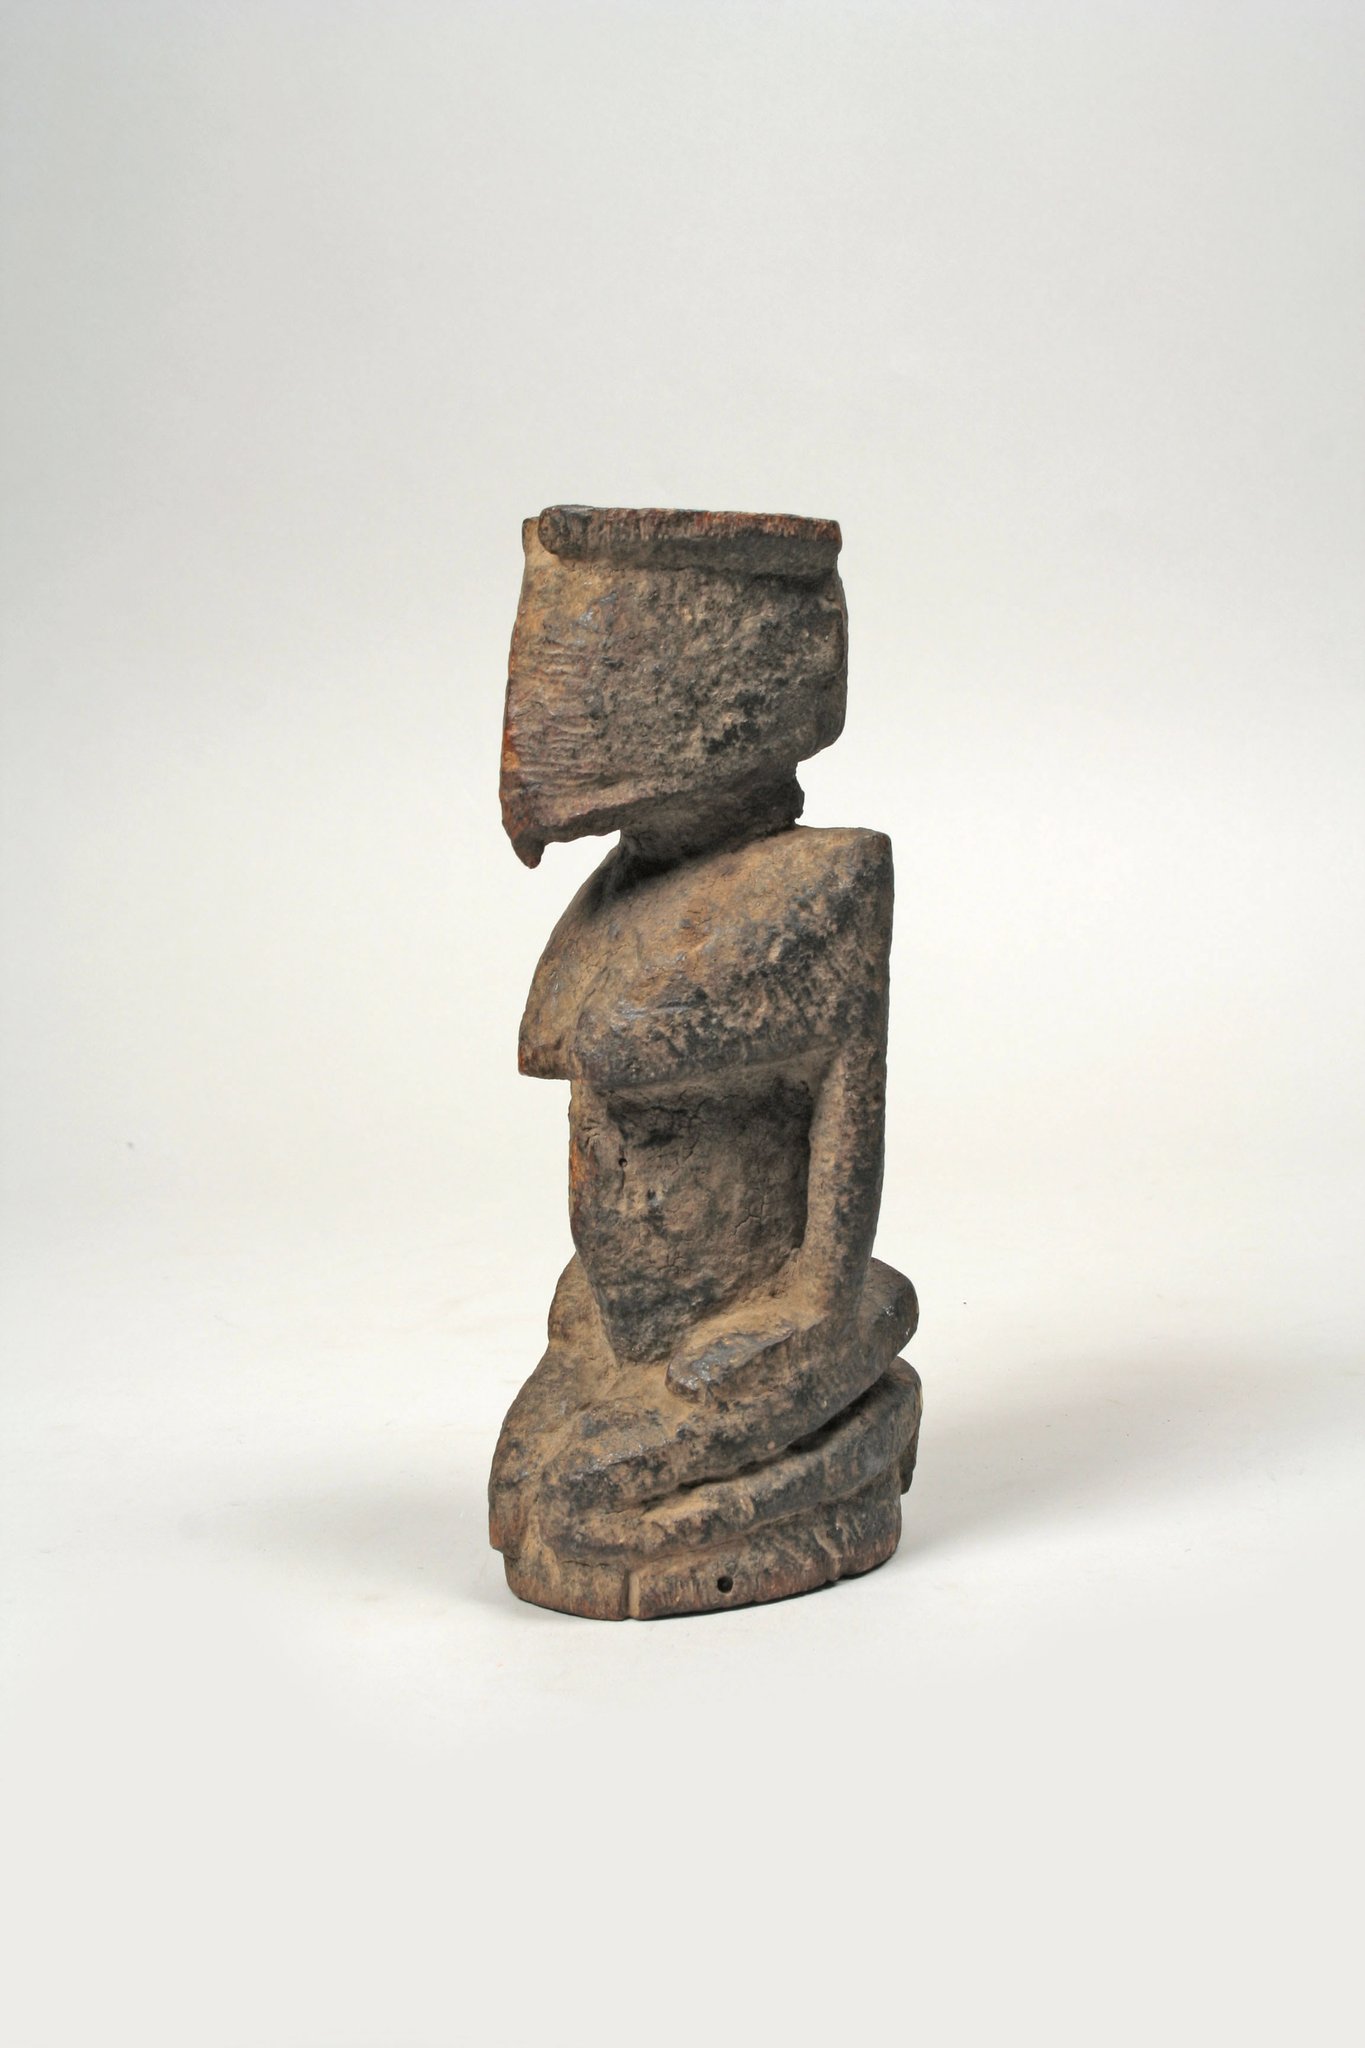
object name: female figure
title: Figure: Kneeling Female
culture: dogon or tellem peoples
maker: dogon or tellem blacksmith (?)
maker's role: artist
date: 1501-1900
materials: wood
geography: mali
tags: female nudes